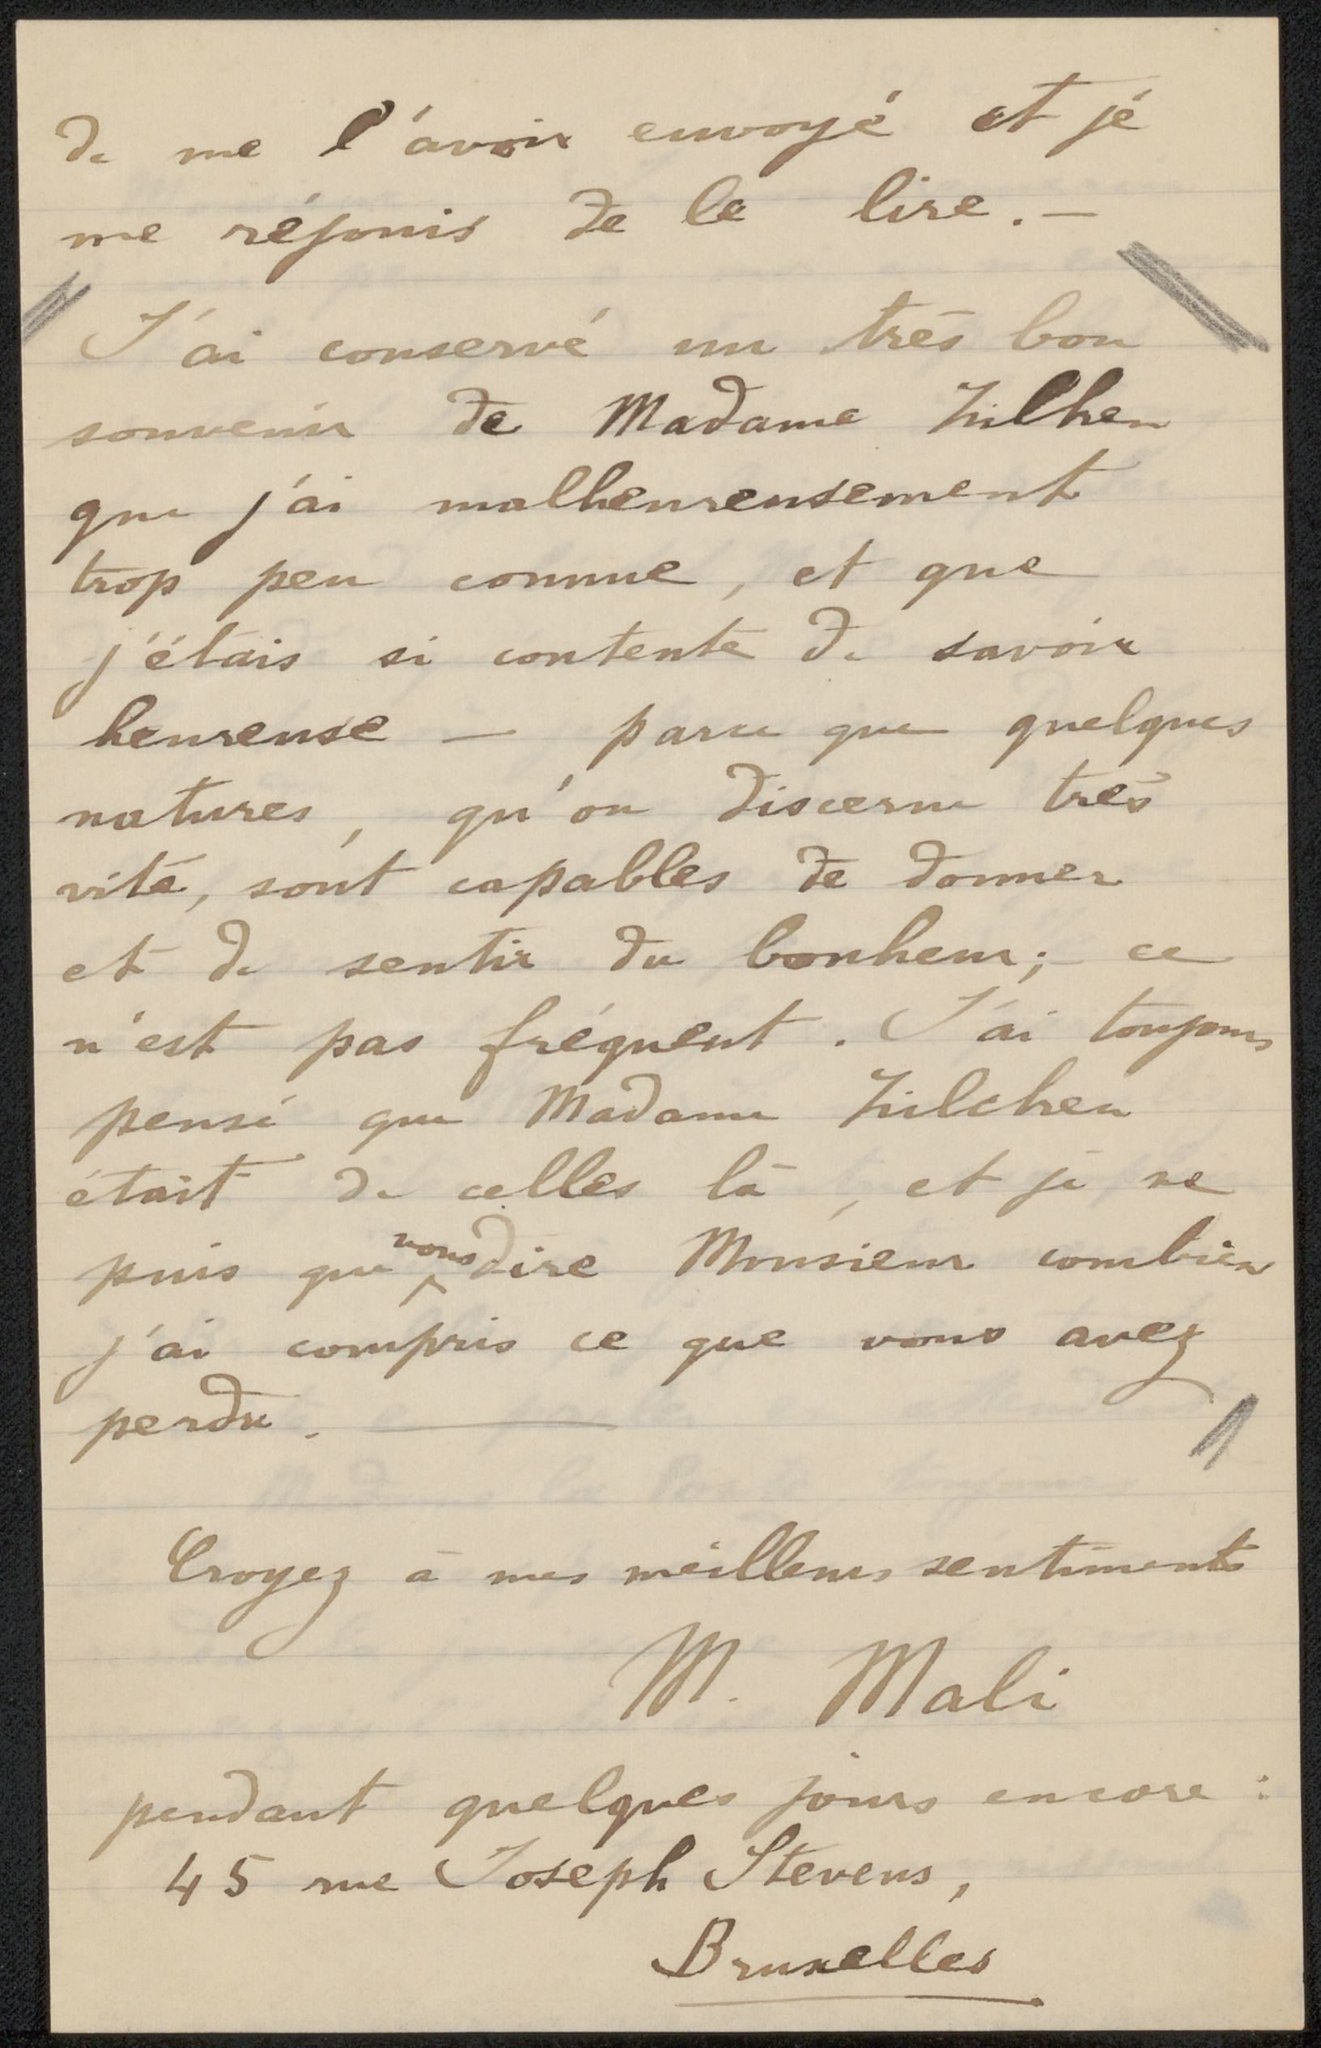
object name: letter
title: Brief aan Philip Zilcken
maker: christian friedrich mali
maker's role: painter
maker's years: 1832-1906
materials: ink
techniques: pen, writing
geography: brussels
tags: brussels, helène lambertine hauzeur, draughtsman, philip zilcken, passions, emotions, affections